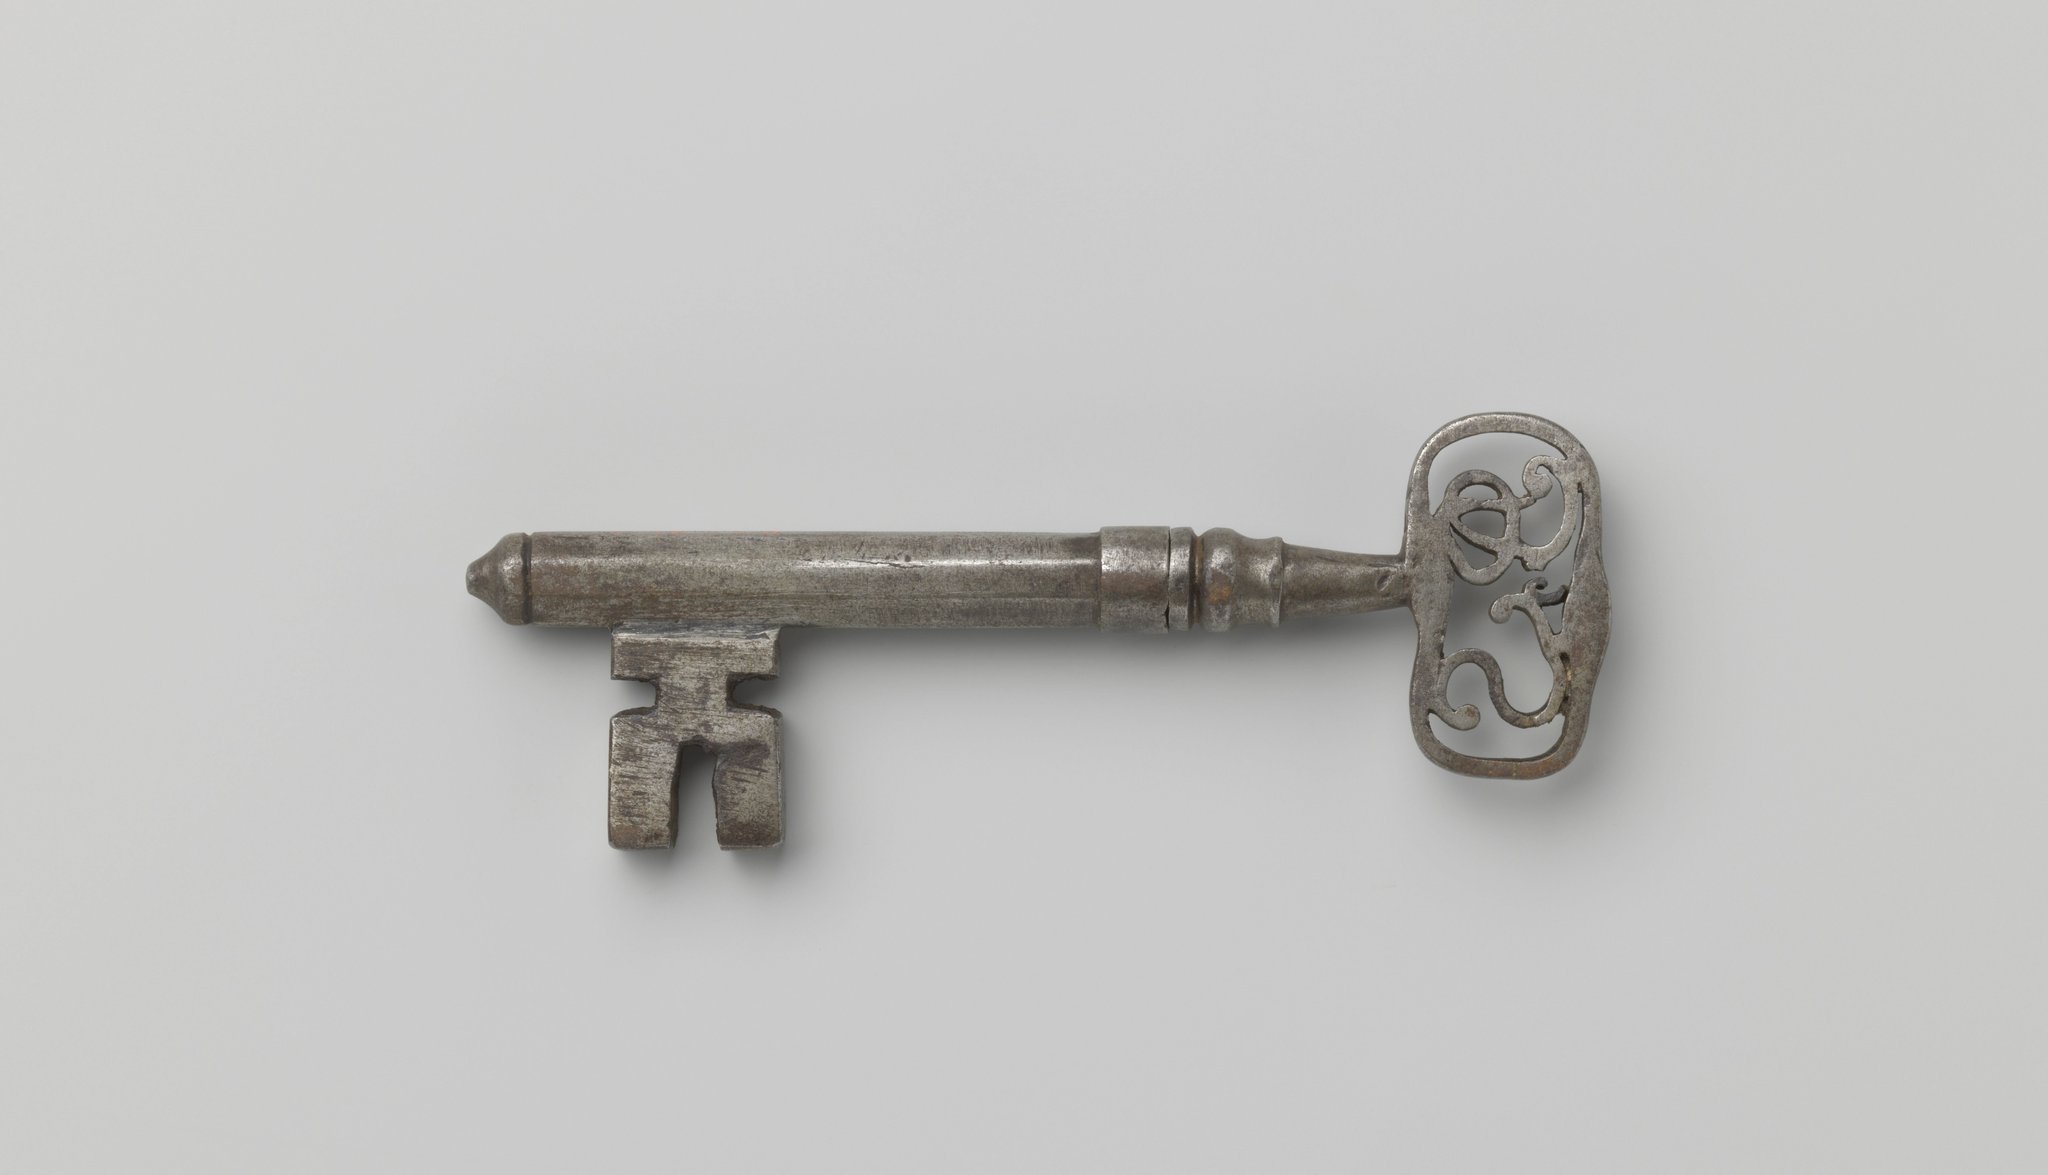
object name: needle case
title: Naaldenkoker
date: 1700-1800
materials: iron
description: Naaldenkoker in de vorm van een sleutel met de omgekeerde initialen A.P.S. in de greep die afschroefbaar is.